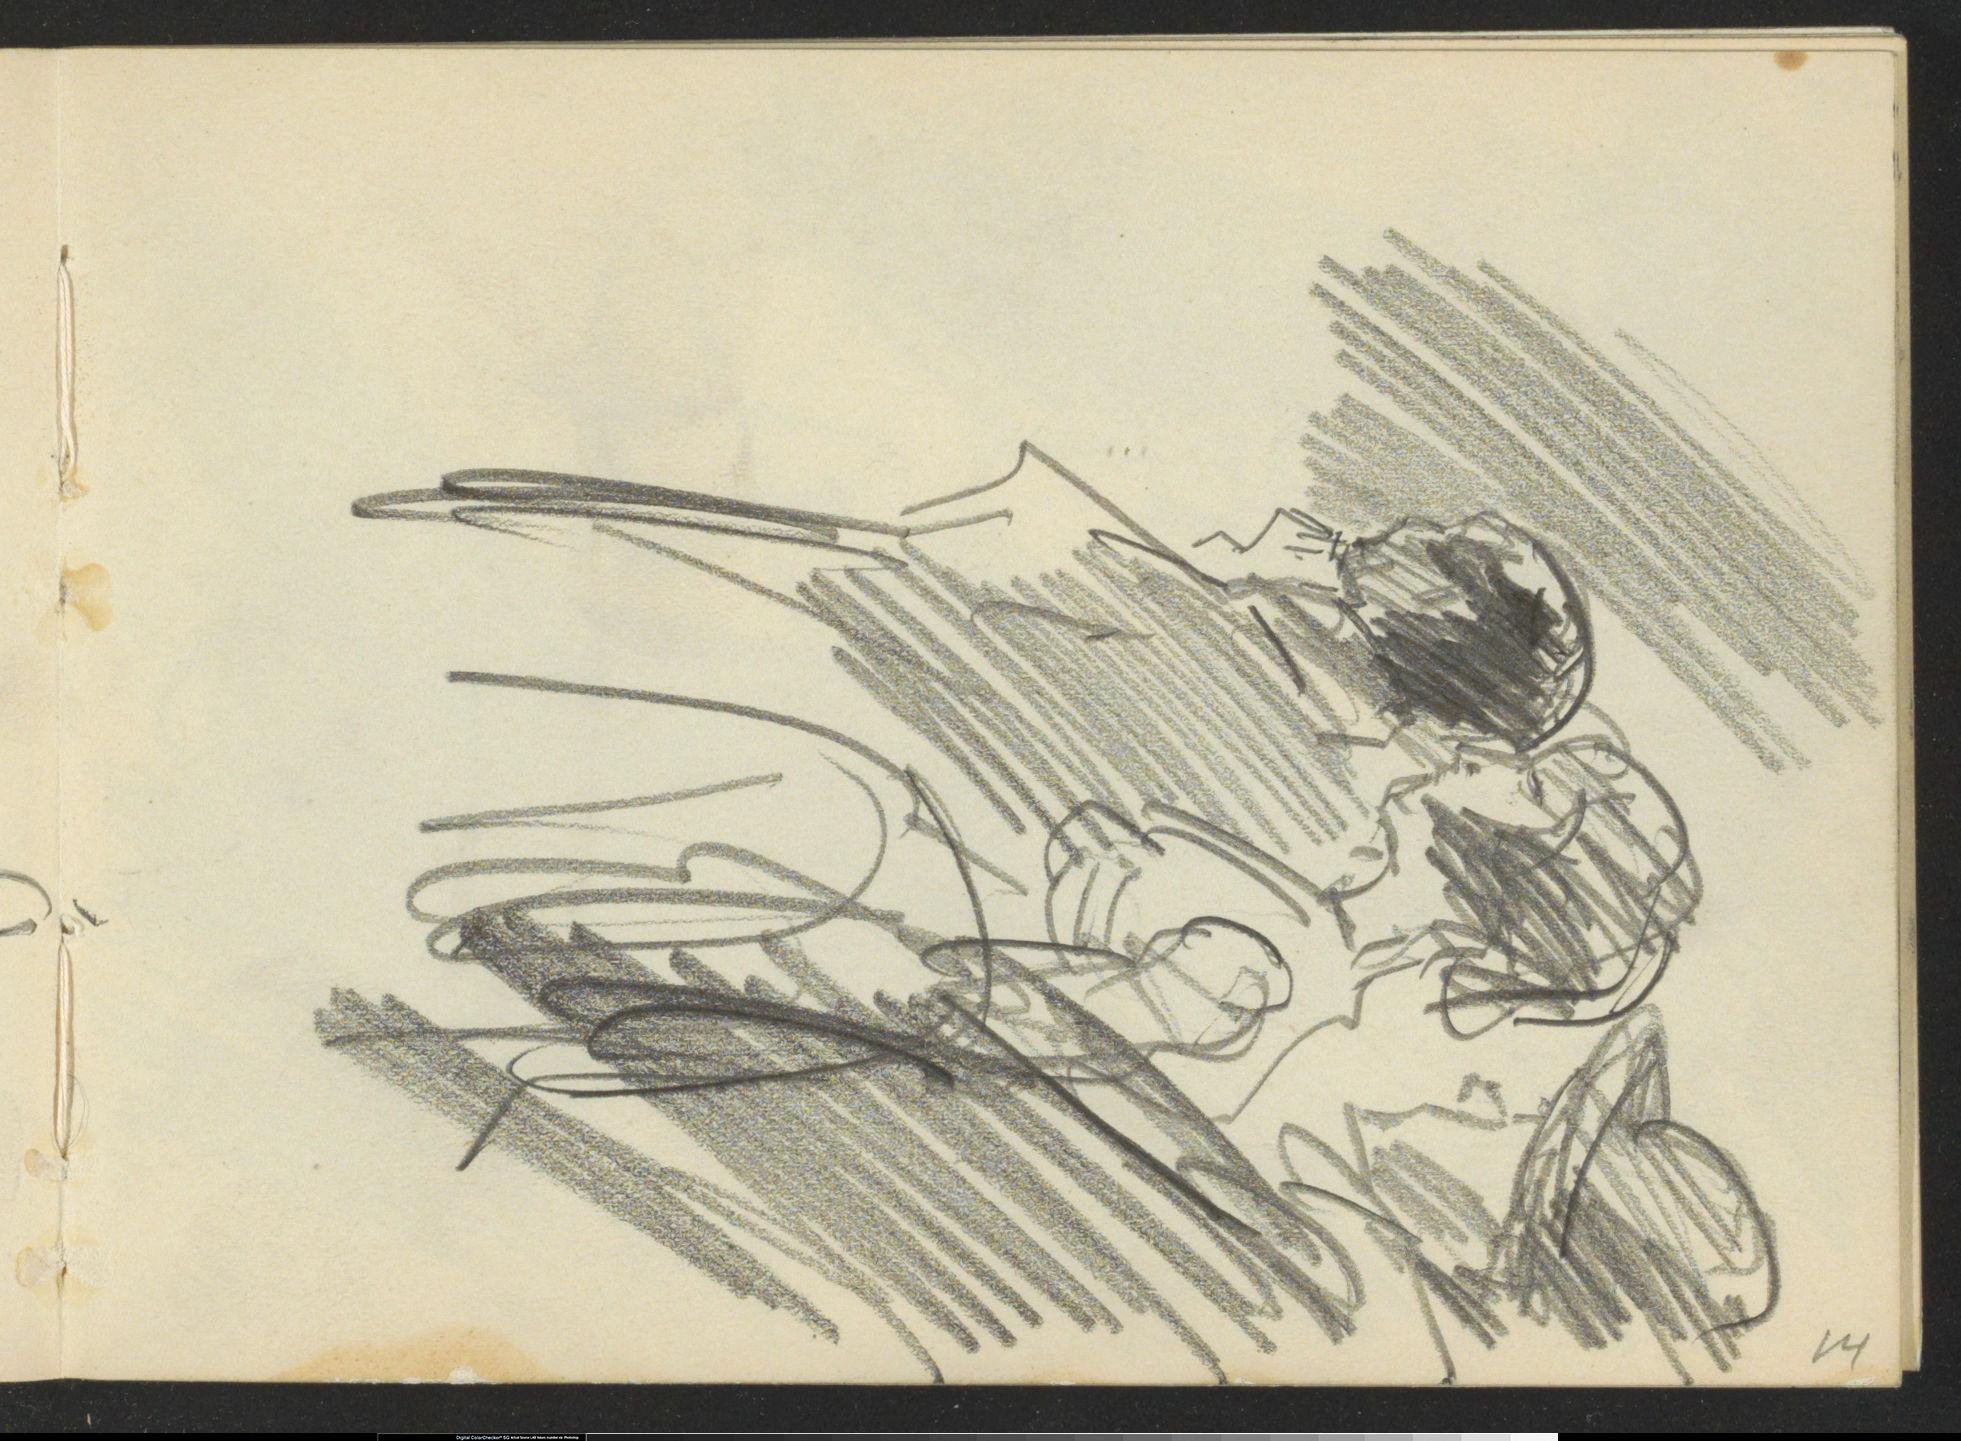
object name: sketchbook leaf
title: Twee staande vrouwen en een man, in profiel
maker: isaac israels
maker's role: draughtsman, painter, print maker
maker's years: 1865-1934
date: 1875-1934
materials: paper, pencil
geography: the hague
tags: adult woman (+ standing), adult man (+ standing)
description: De man draagt een hoed. Blad 14 recto uit schetsboek LXV met 27 bladen.